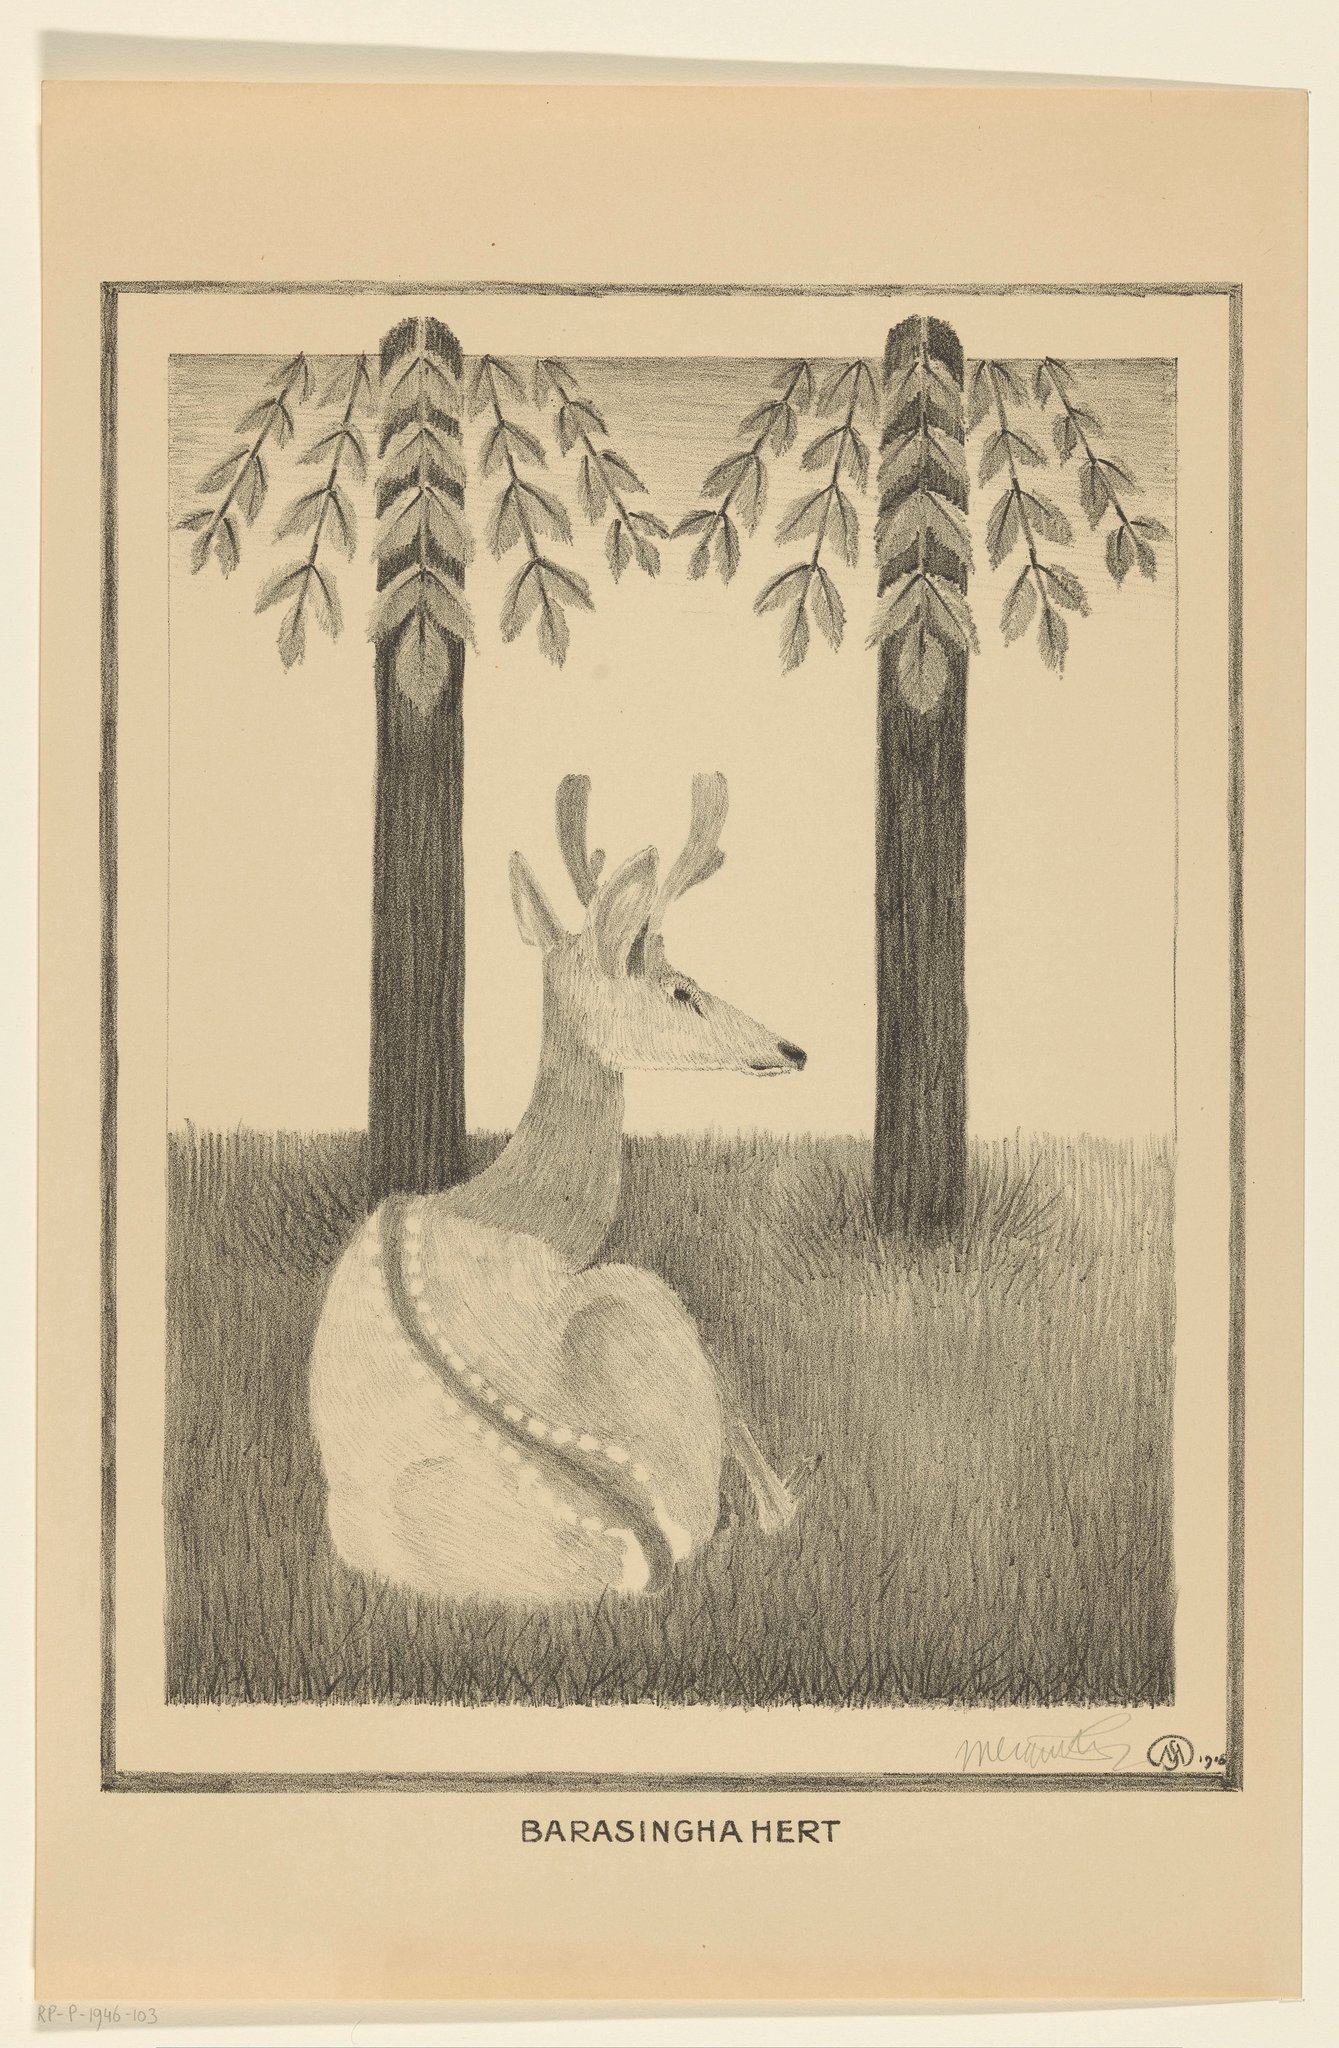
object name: print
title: Barasinghahert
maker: samuel jessurun de mesquita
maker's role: draughtsman, print maker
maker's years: 1868-1944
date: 1916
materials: paper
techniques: lithograph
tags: hoofed animals: deer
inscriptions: collector's mark: Lugt 2228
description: Prent gebruikt voor: De nieuwe Amsterdammer. Onafhankelijk Nederlandsch weekblad. Amsterdam: Maatschappij voor Goede en Goedkope Lectuur, 24 juni 1916.